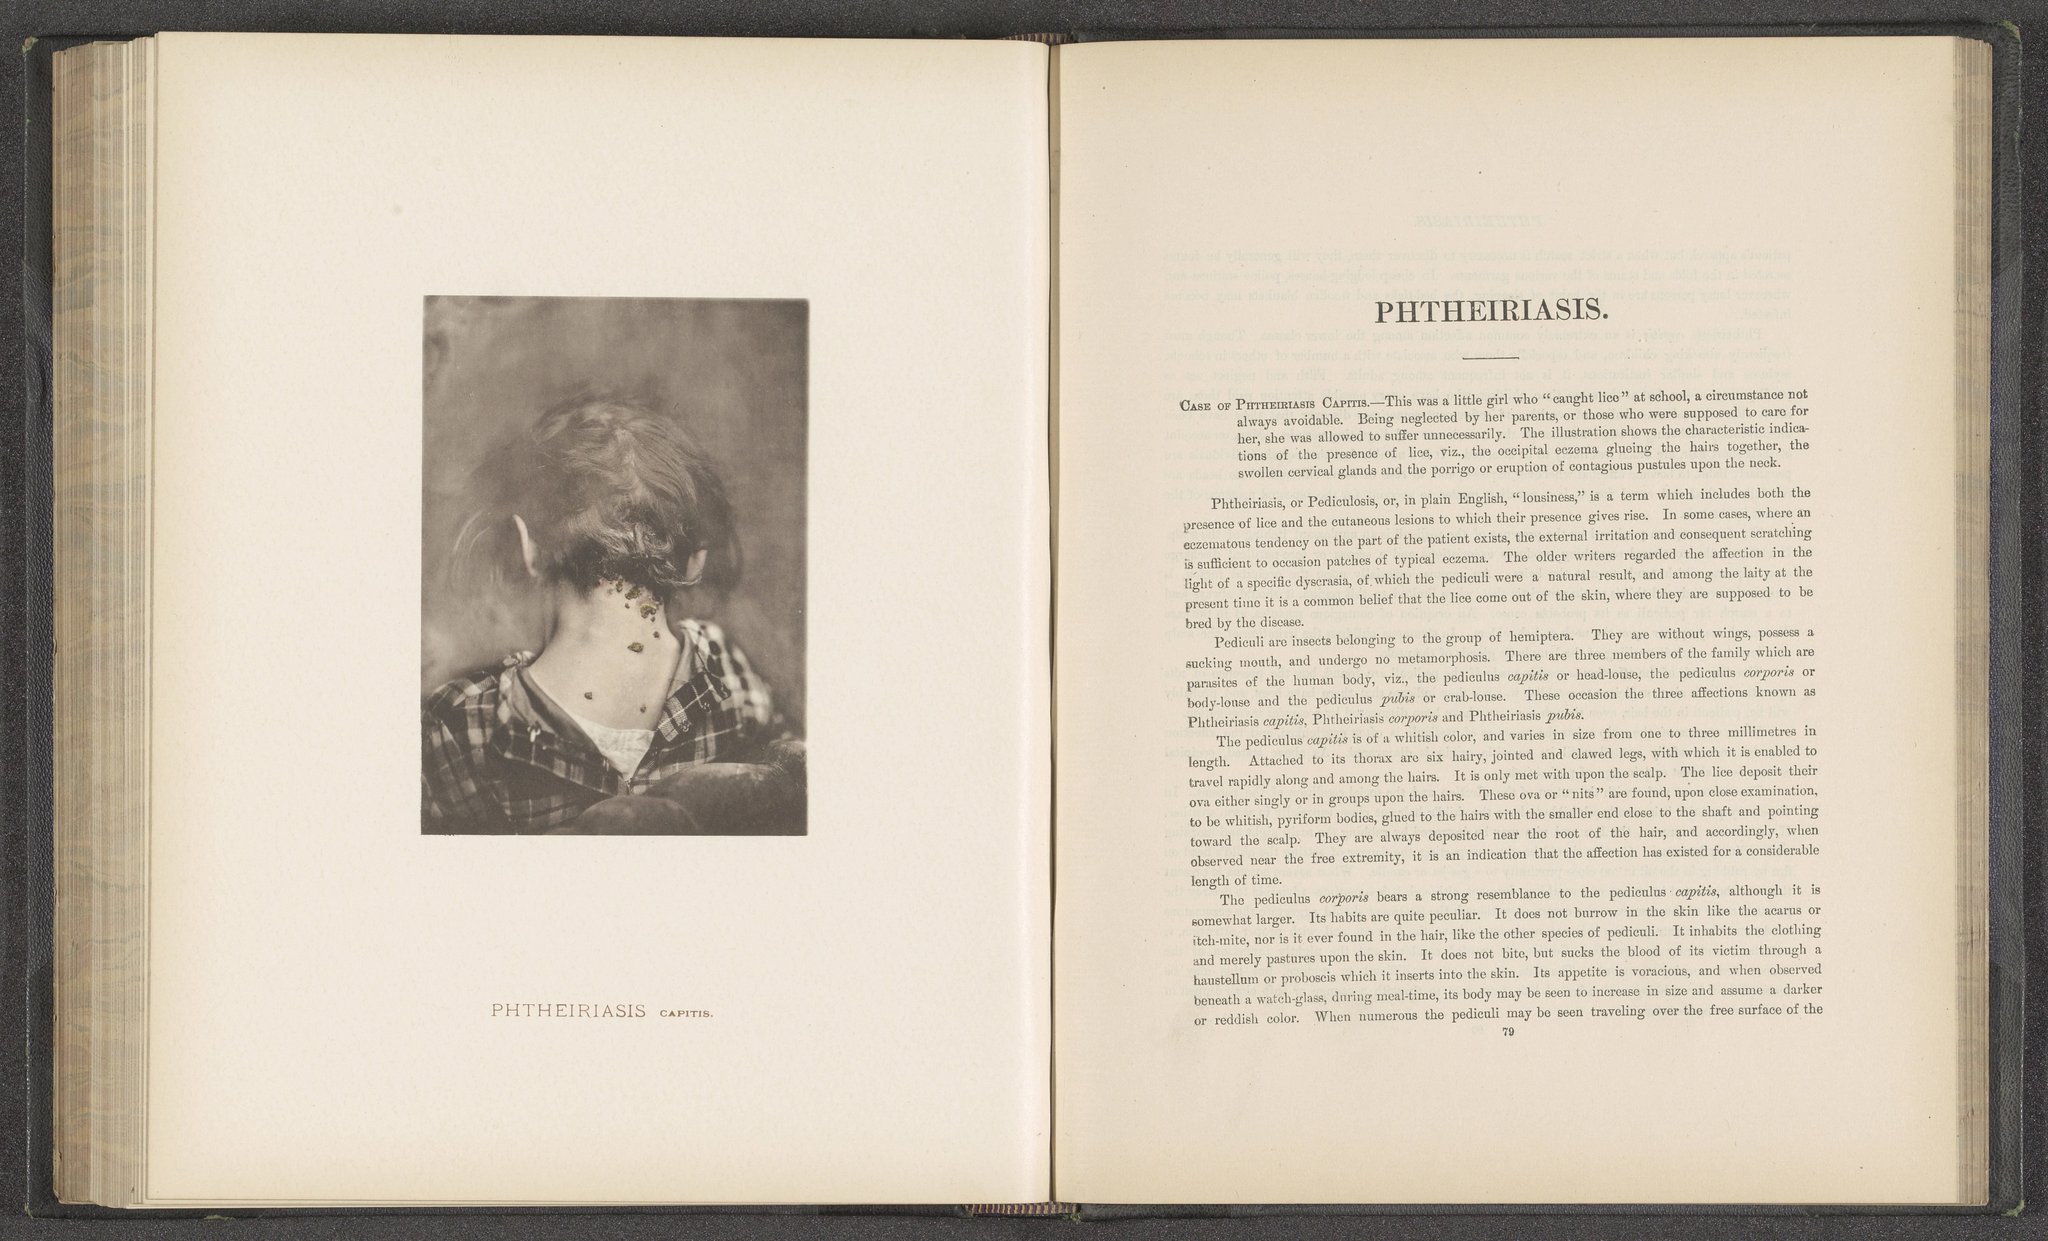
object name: photomechanical print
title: Patiënt lijdend aan de huidziekte 'phtheiriasis capitis'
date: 1870-1881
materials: paper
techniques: photograph, hand coloring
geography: new york city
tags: head (human), skin and venereal diseases, hair